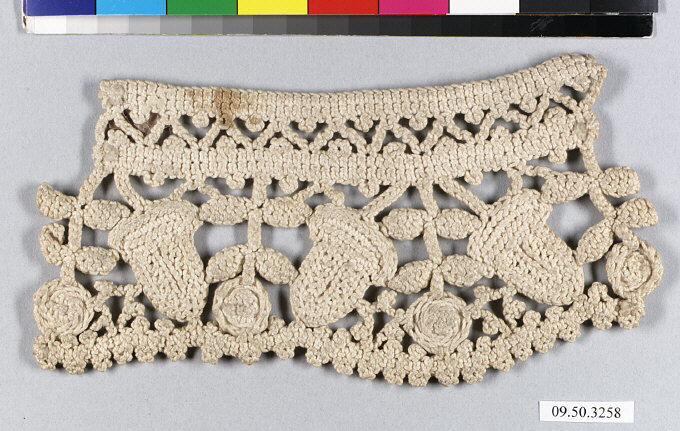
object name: sample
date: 1801-1900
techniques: crochet